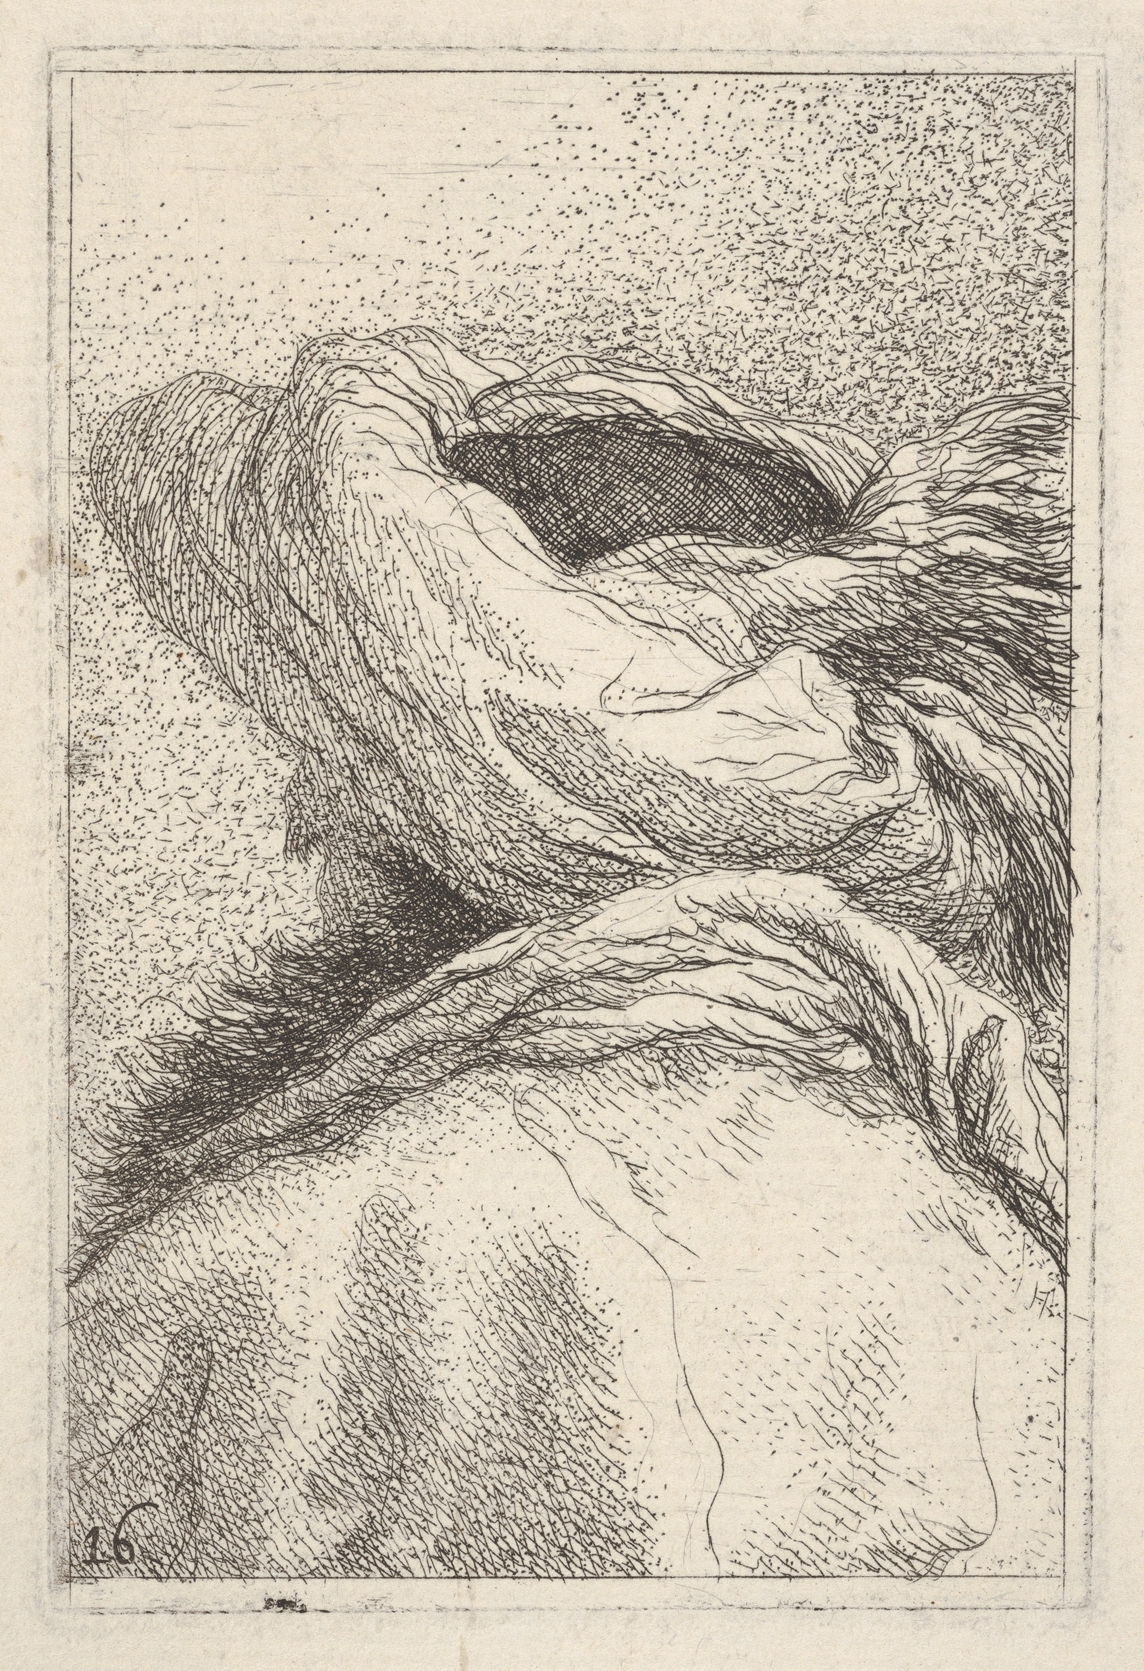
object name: print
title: Man in a turban, depicted in bust length format from behind in three-quarters view, from "Collection of heads" (Raccolta di teste)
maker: giovanni domenico tiepolo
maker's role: artist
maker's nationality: italian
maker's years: 1727-1804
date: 1770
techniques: etching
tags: men